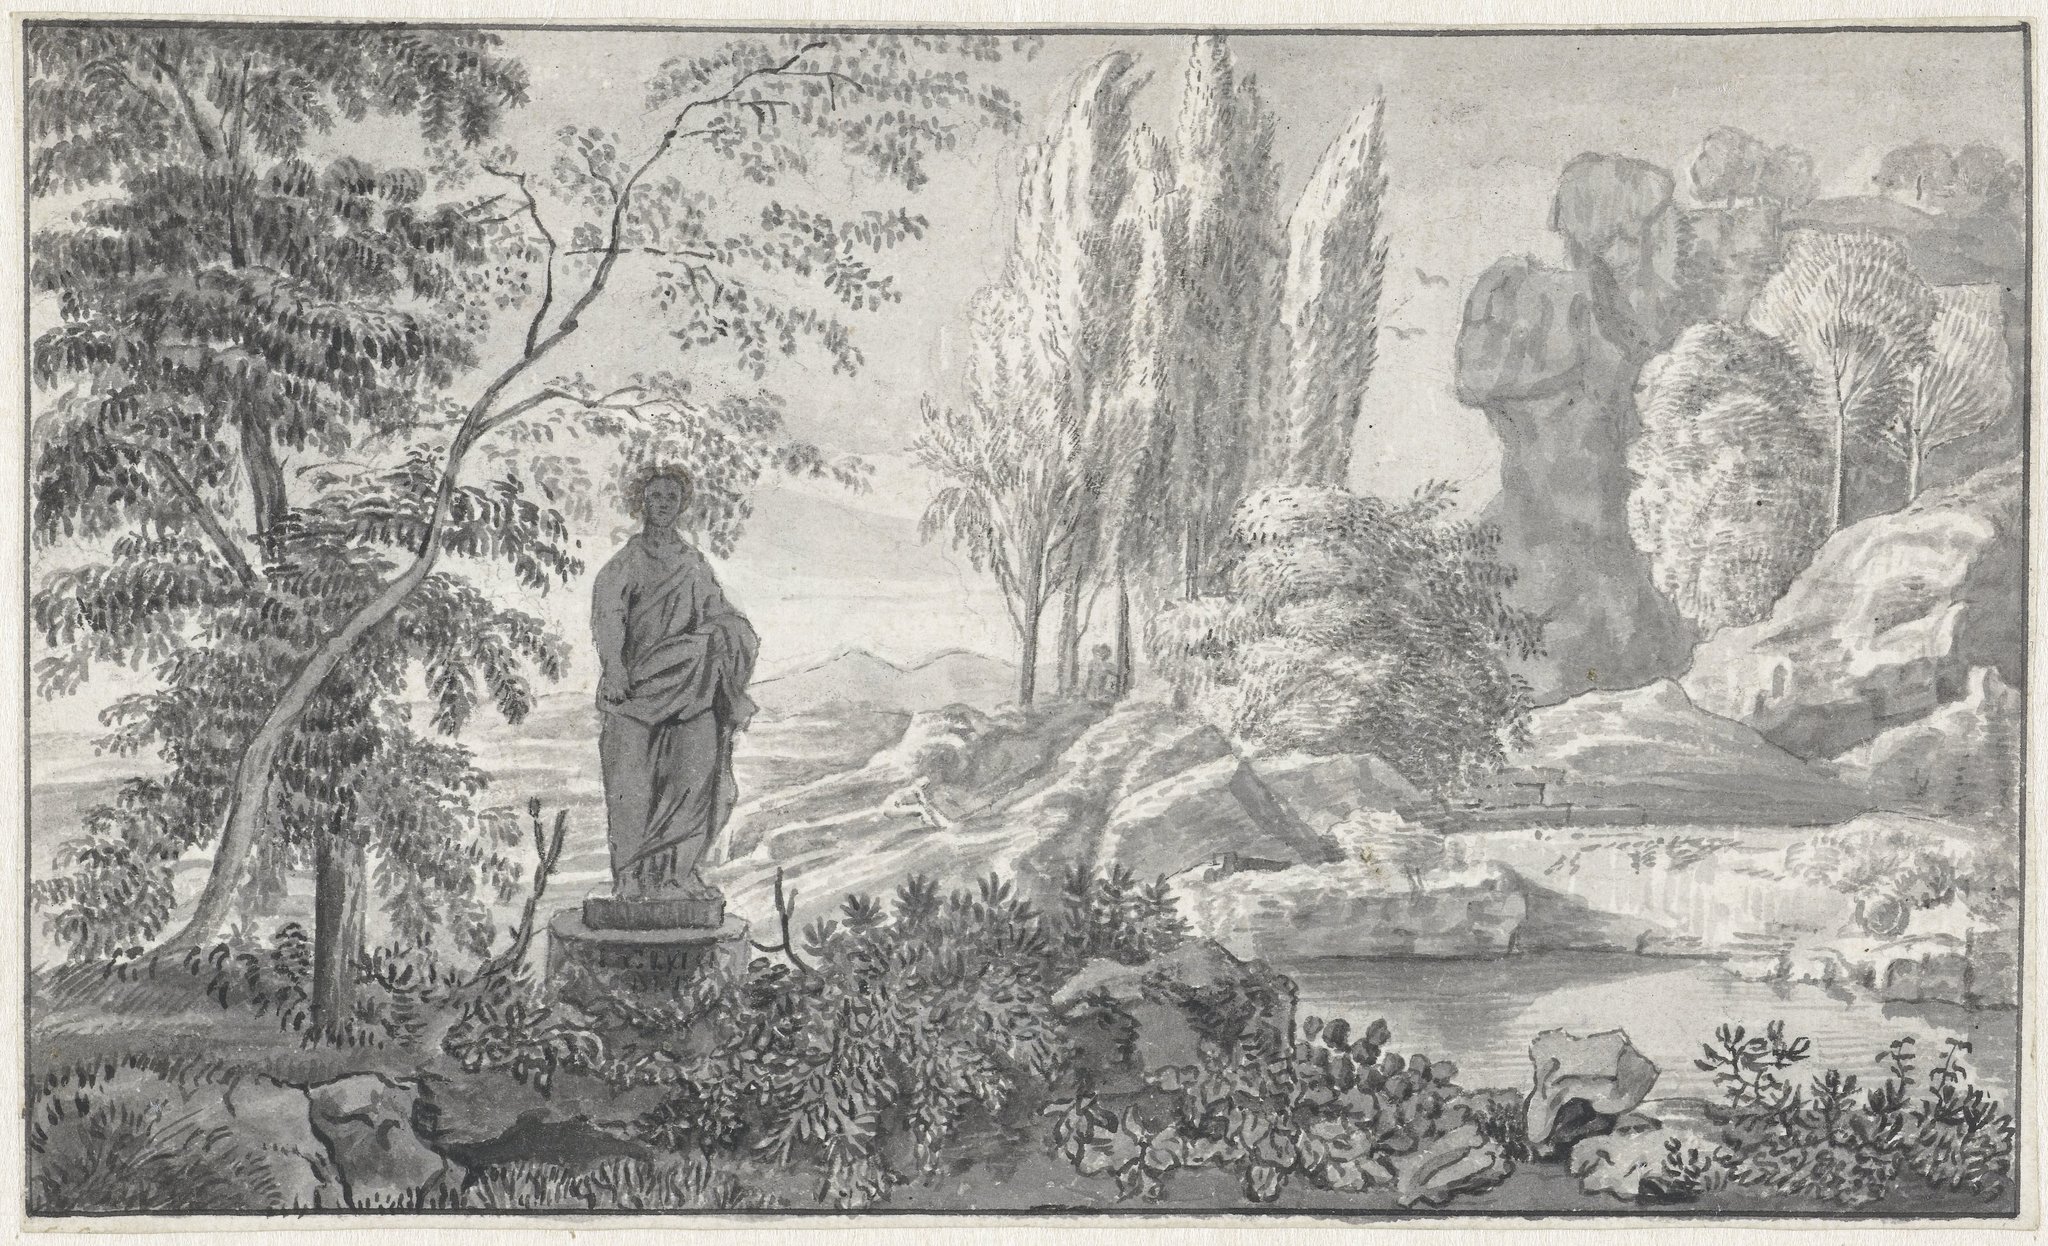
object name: drawing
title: Arcadisch landschap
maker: Anonymous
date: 1700-1800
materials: ink, paper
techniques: brush, pen